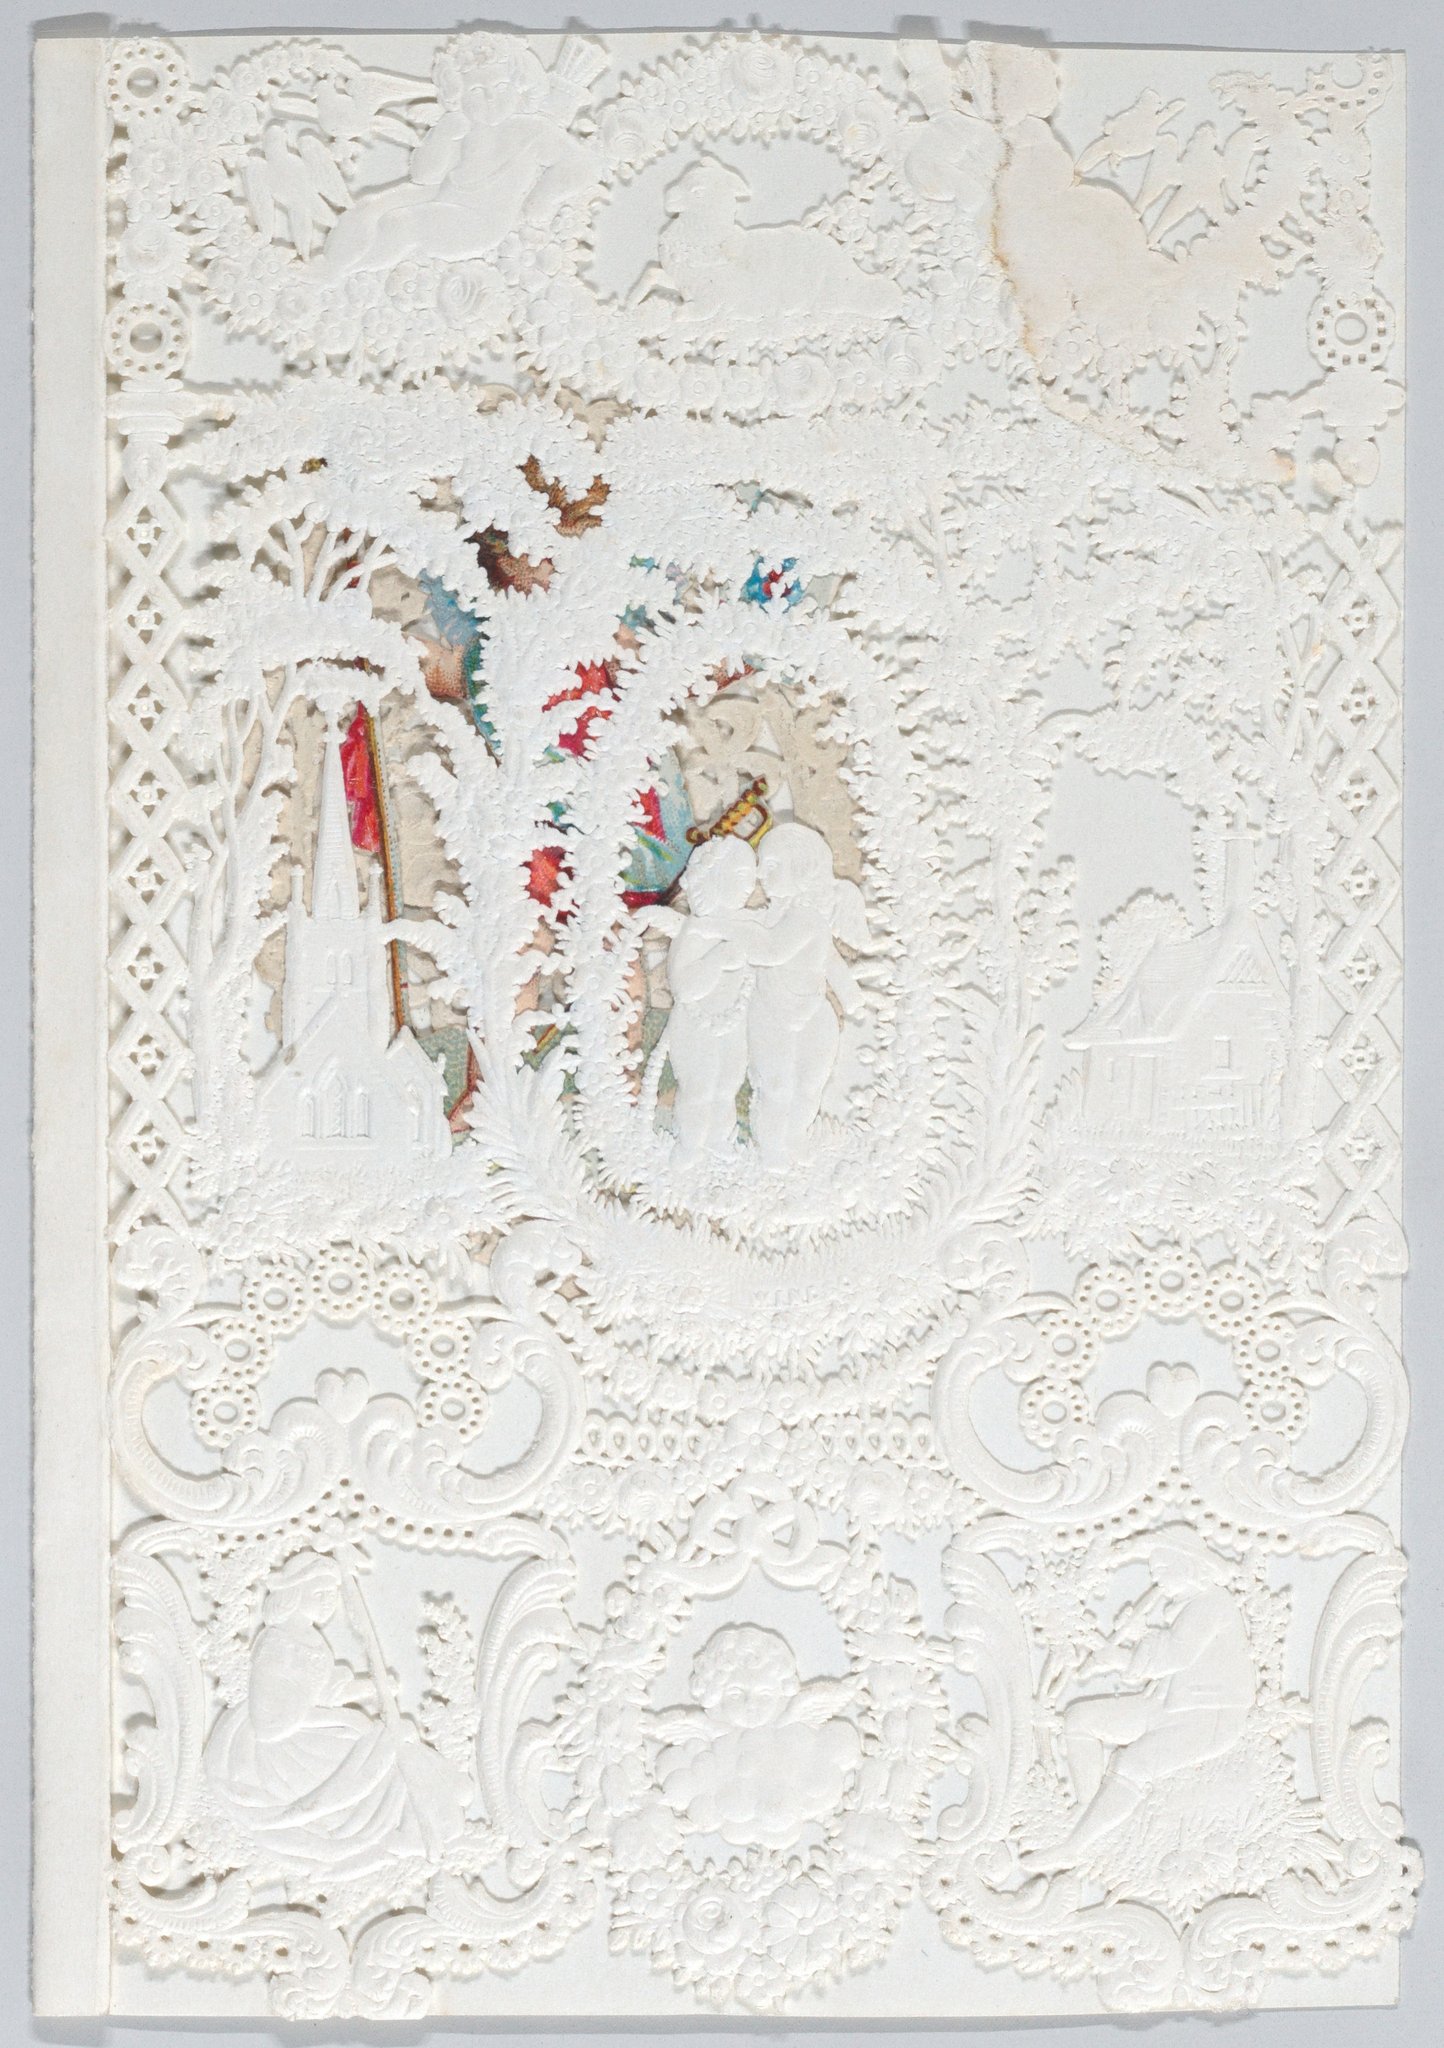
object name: valentine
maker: Anonymous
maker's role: artist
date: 1834-1866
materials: lace, paper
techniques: cutting, embossing, open work